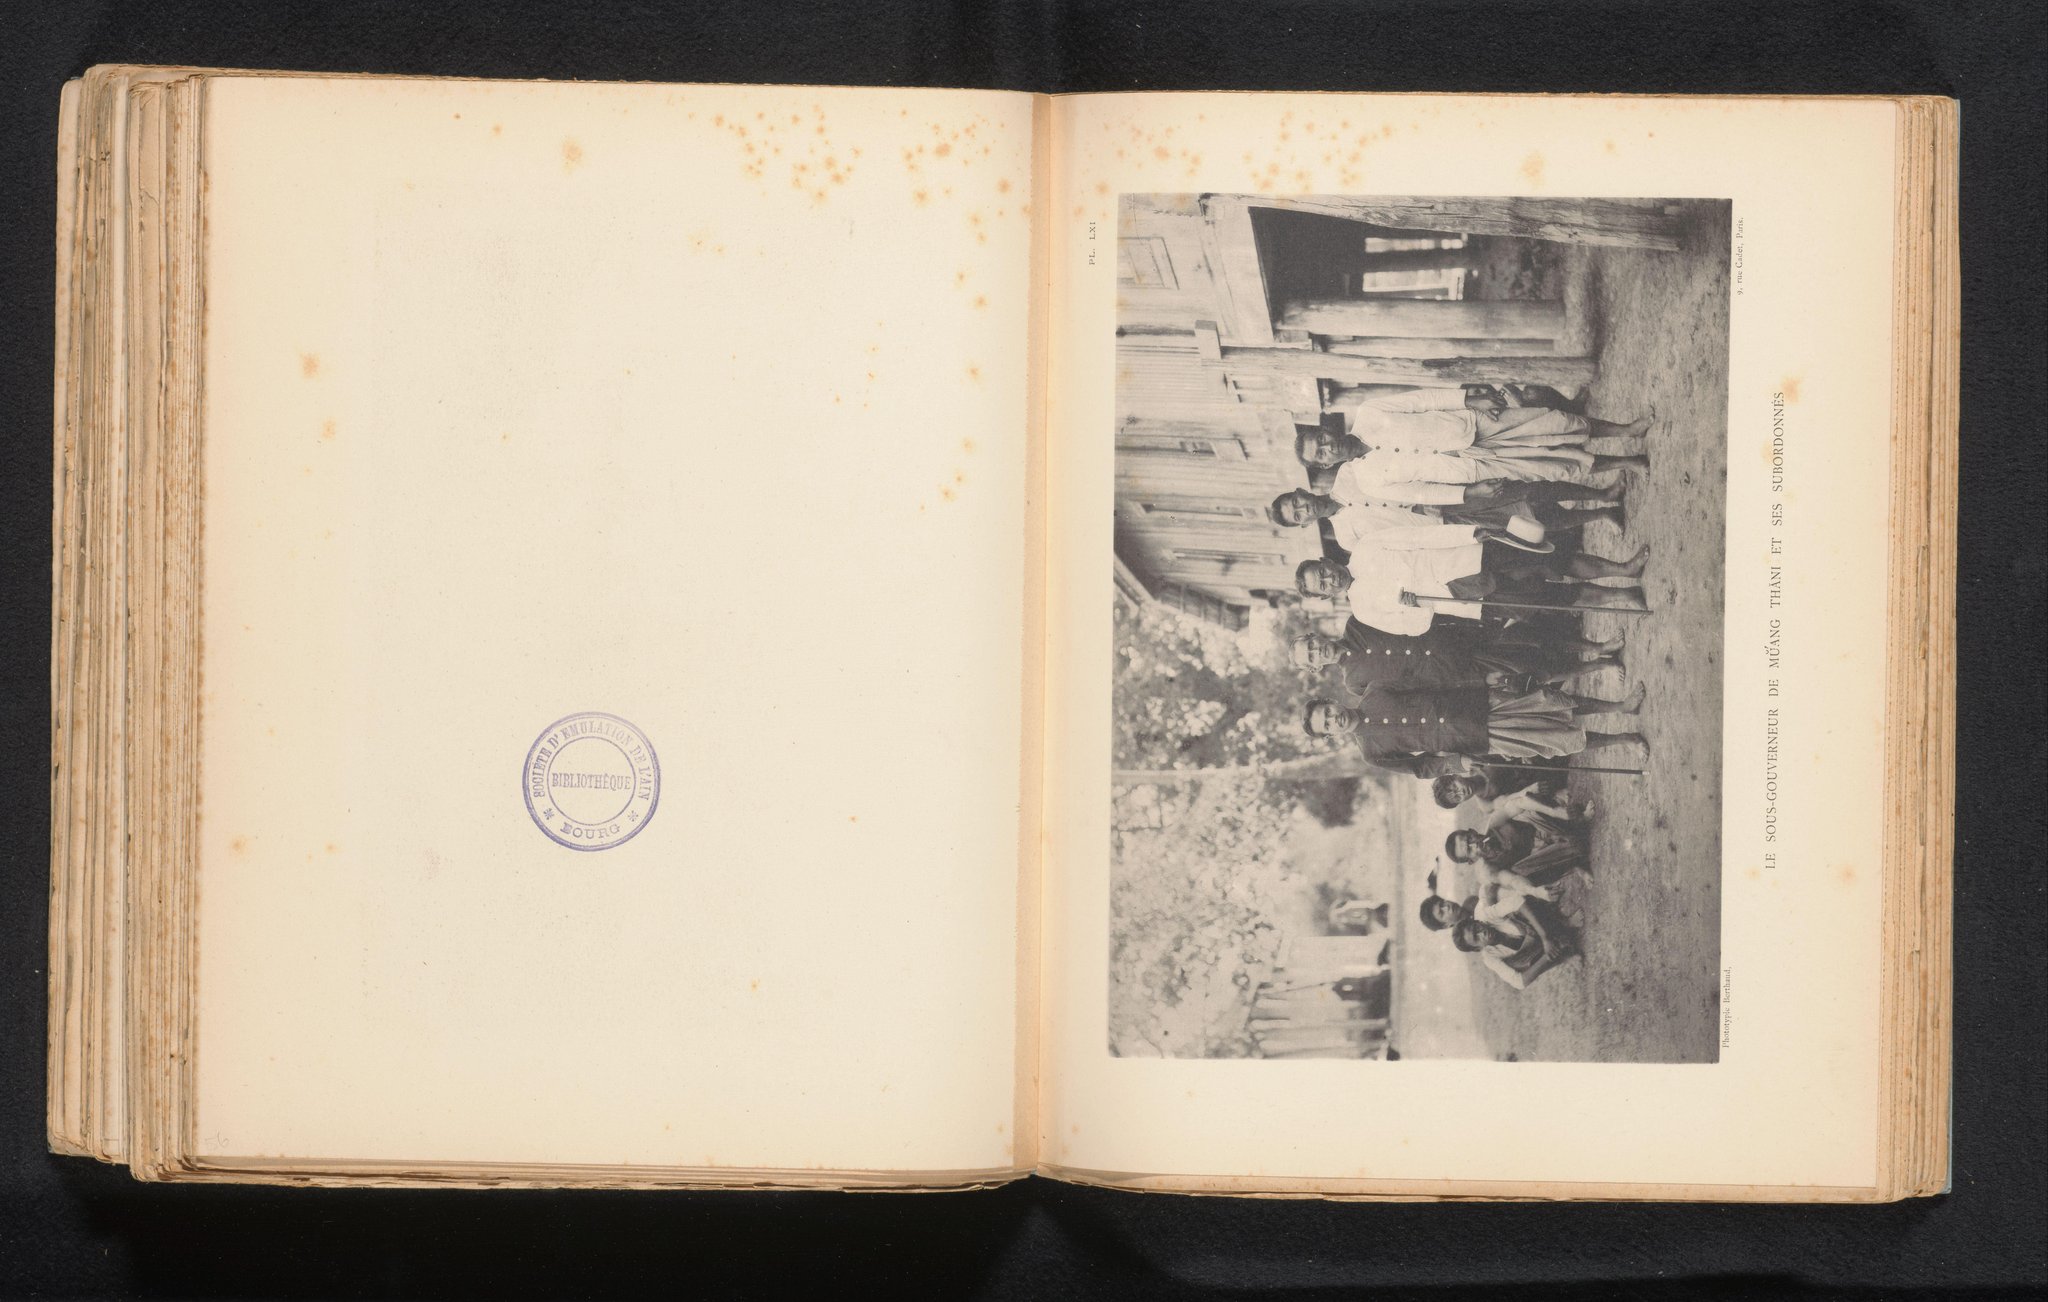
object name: photomechanical print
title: Groepsportret van onbekende mannen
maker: michel berthaud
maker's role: publisher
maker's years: 1845-1912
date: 1890-1895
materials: paper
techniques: photograph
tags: adult man, anonymous historical persons portrayed in a group, in a group-portrait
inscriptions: inscription: ‘Pl. LXI’, collector's mark: ‘Société d'Emulation de l'Ain/ Bourg/ Bibliothèque’